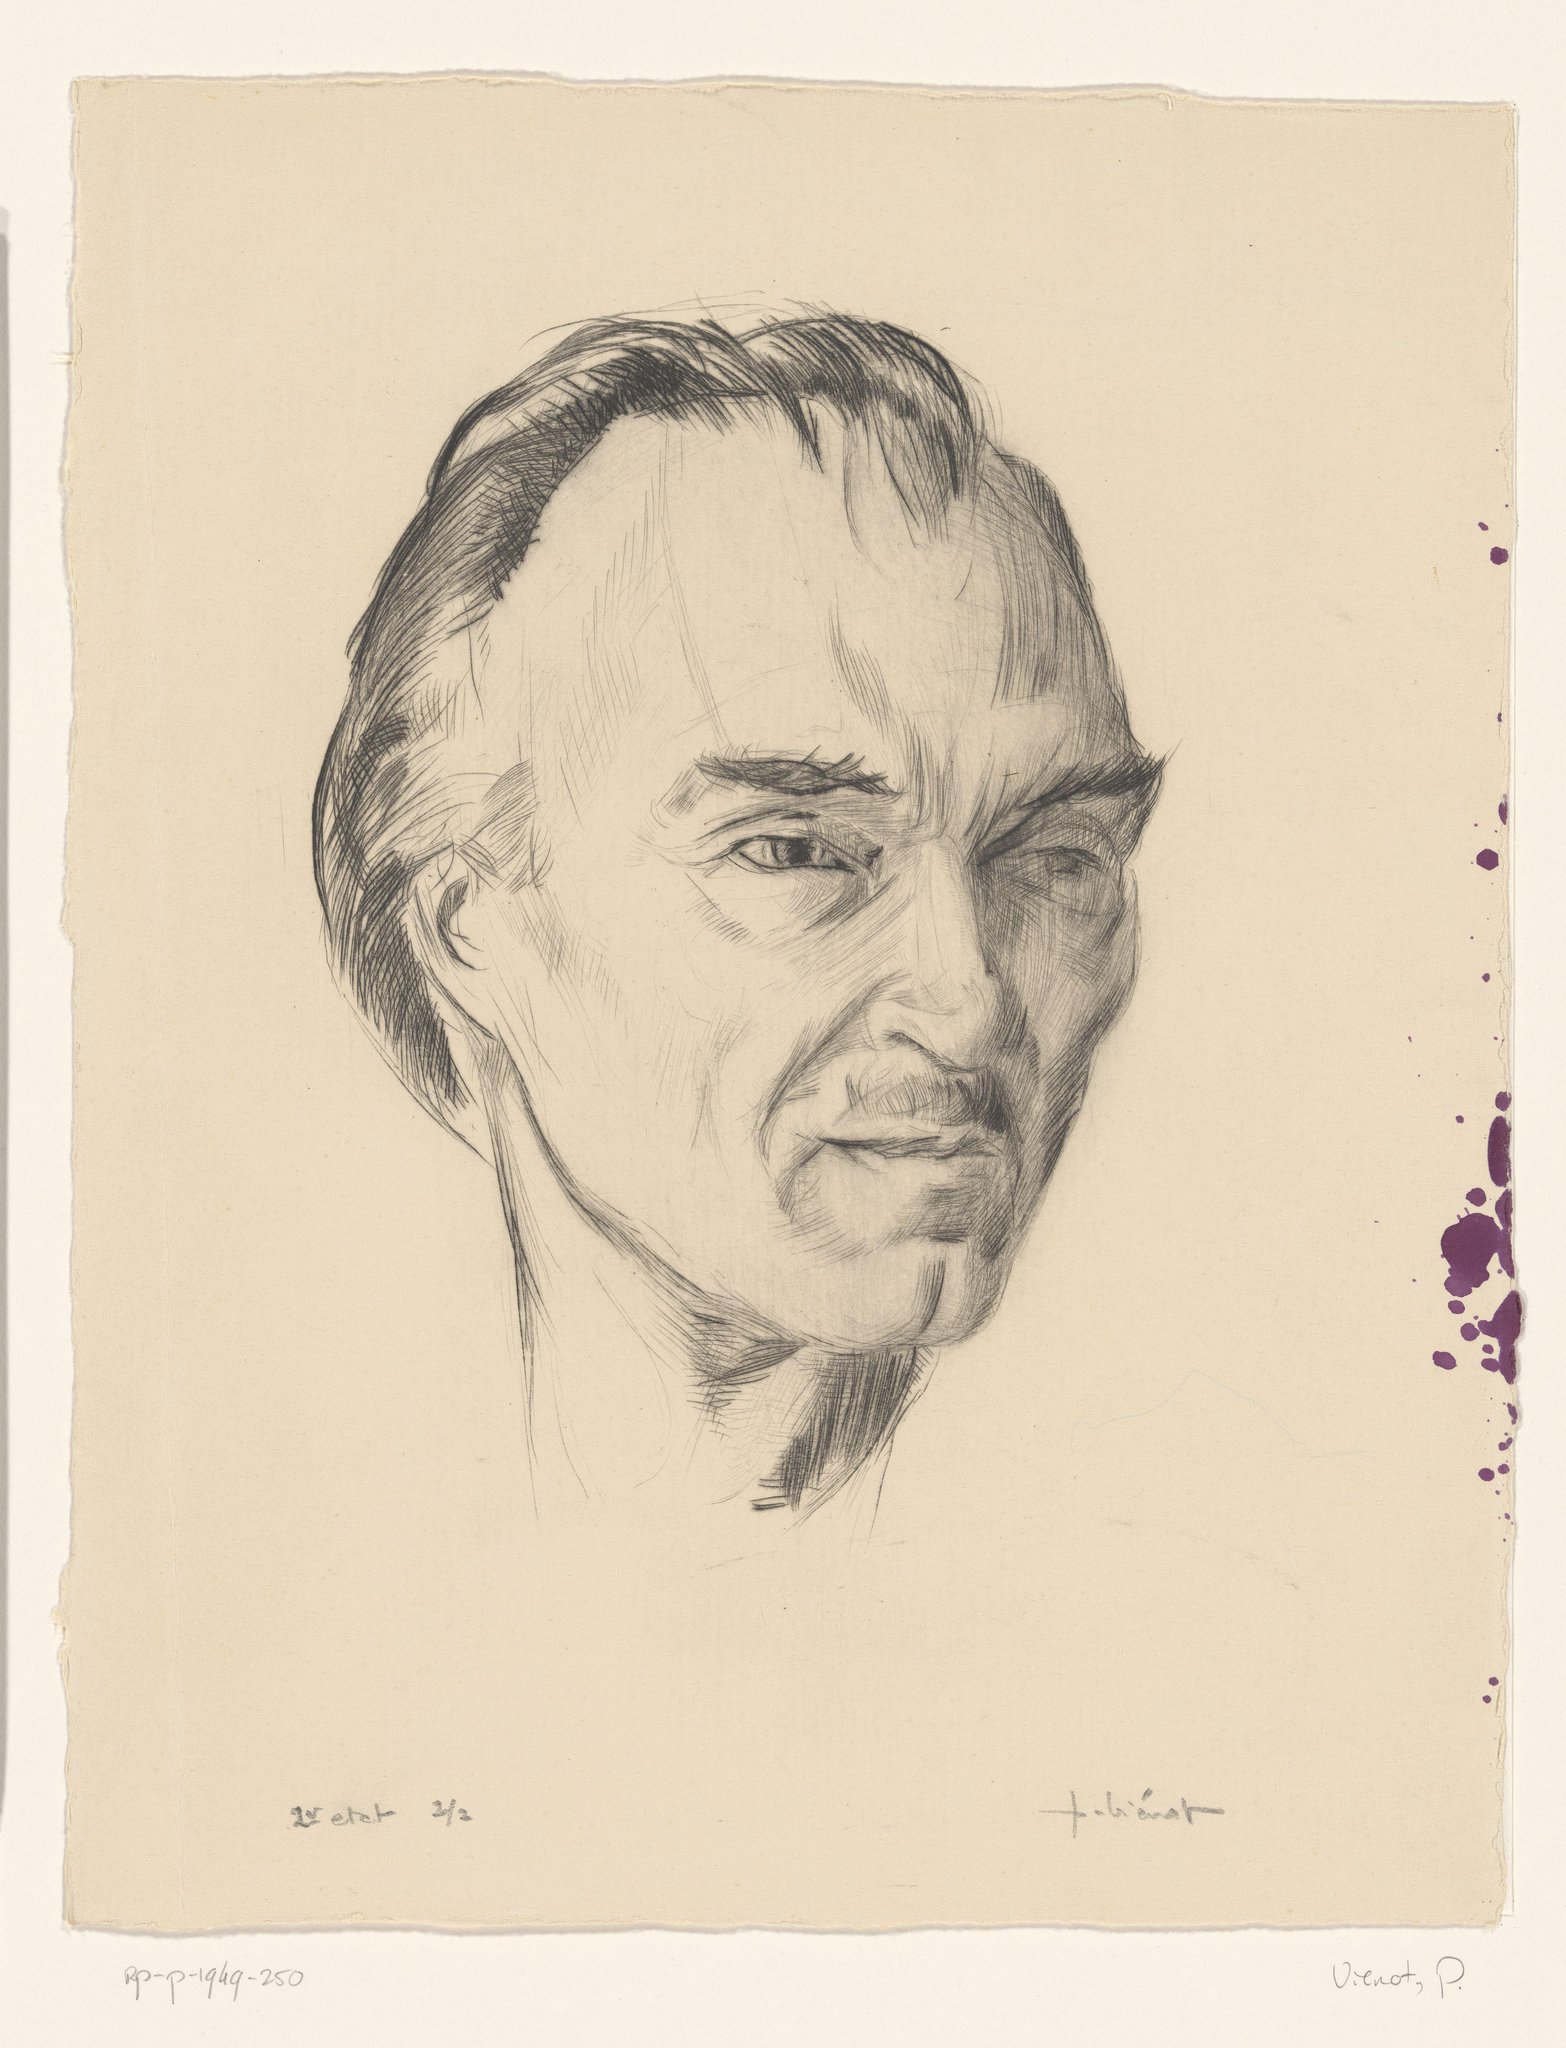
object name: print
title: Portret van J.H. Adam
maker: pierre vienot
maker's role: print maker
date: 1900-1949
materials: paper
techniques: drypoint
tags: historical persons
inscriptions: collector's mark: Lugt 2228